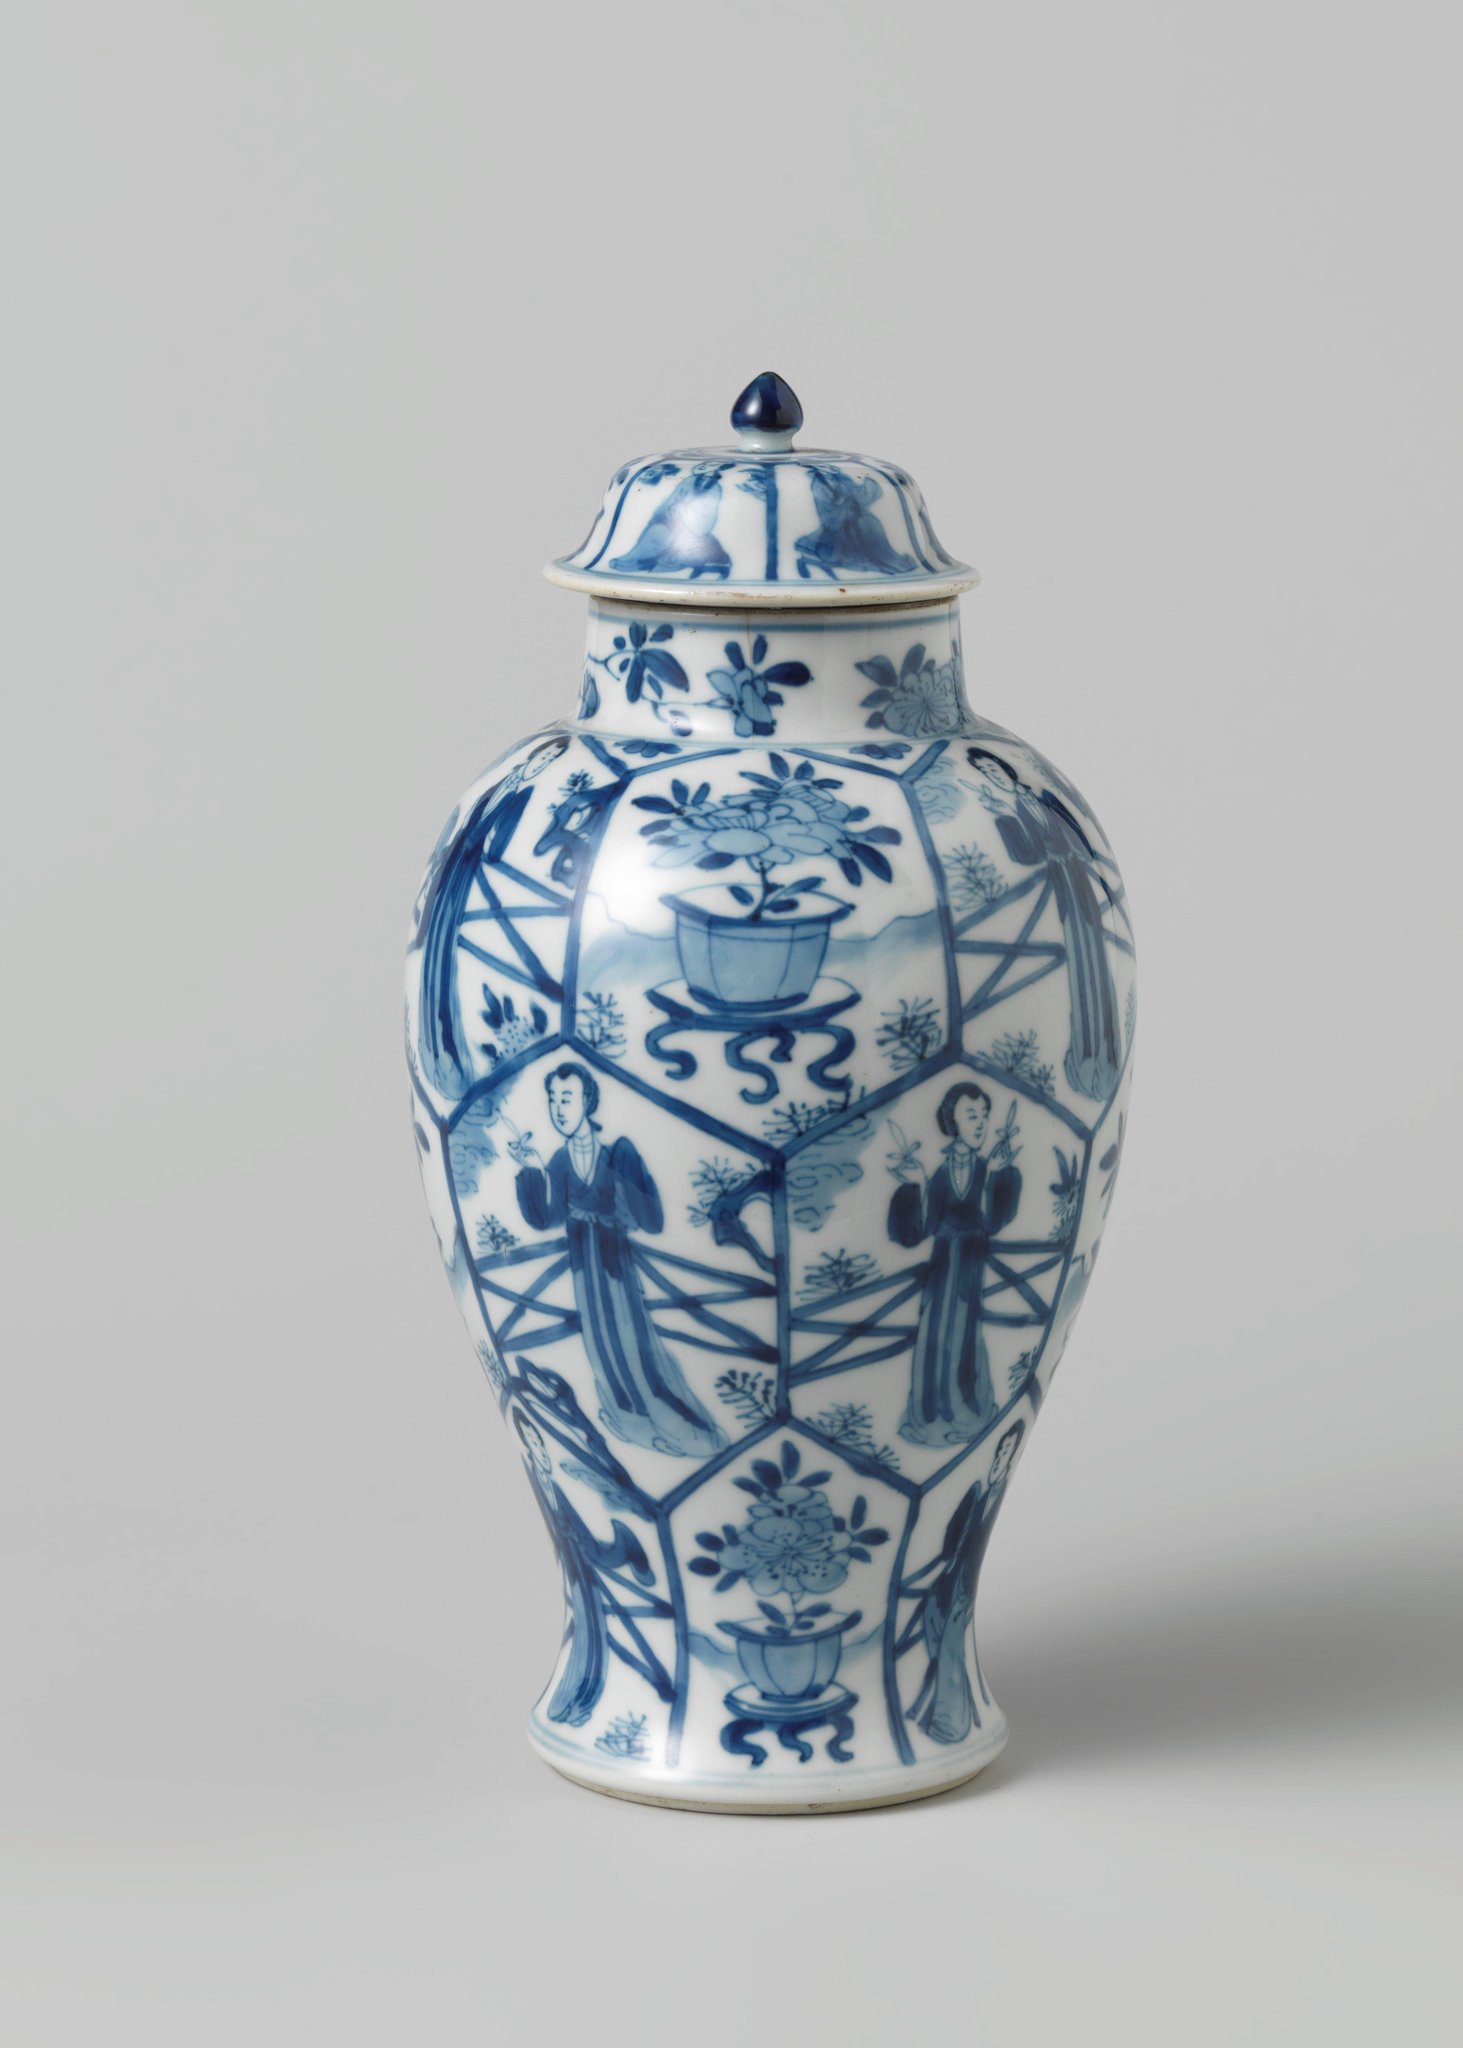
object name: covered jar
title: Covered jar with women and flower pots in panels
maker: Anonymous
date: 1680-1720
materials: cobalt, glaze, paint, porcelain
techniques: firing, turning, vitrification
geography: china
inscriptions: mark: ‘玉 Yù’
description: Balustervormige dekselpot van porselein, beschilderd in onderglazuur blauw. De wand is verdeeld in drie rijen met zeshoekige vakken met daarin afwisselend een vrouw (lange lijs) in een omheinde tuin en een bloemenvaas in een landschap. Op de schouder twee bloemtakken. De deksel met dezelfde decoratie. Gemerkt op de onderzijde met het karakter 'yù', jade, in een dubbele cirkel. Een barst in de rand. Onderdeel van een kaststel met nummer AK-RBK-16290. Blauw-wit.